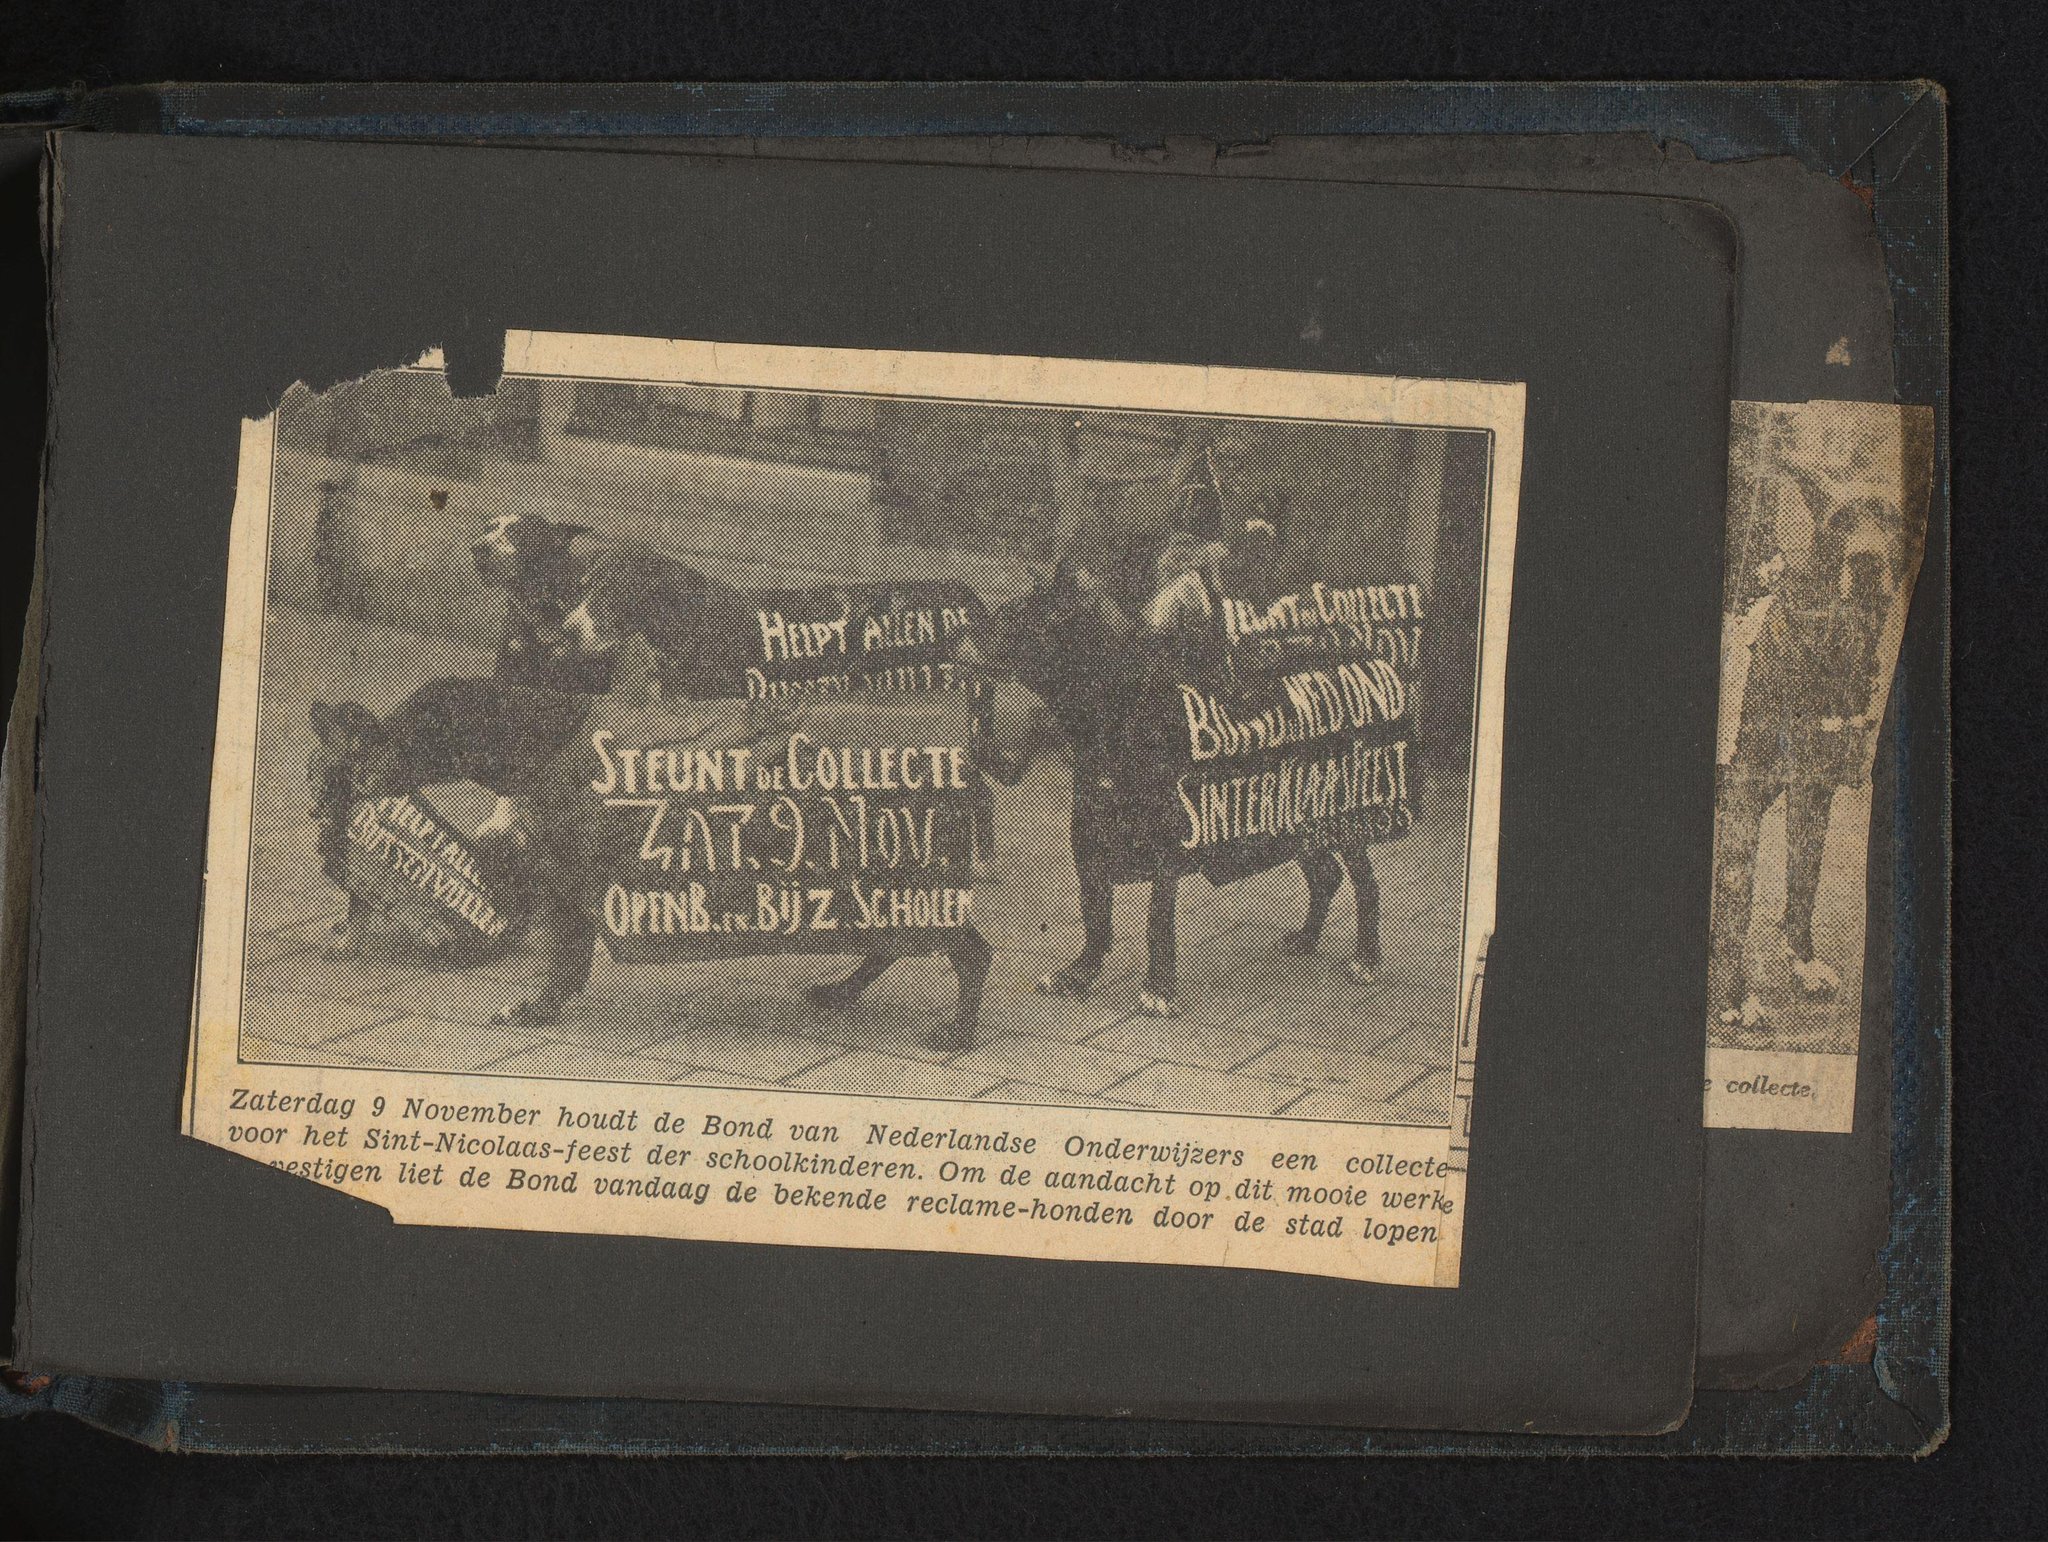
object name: newspaper clipping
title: Honden van de poppendokter met reclameteksten voor het Sinterklaasfeest en poppen op de rug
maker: Anonymous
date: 1930-1940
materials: paper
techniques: autotype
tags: advertising, dolls for adults, dog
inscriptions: inscription: ‘Zaterdag 9 November houdt de Bond van Nederlandse Onderwijzers een (...)’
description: Deze prent maakt deel uit van een album.